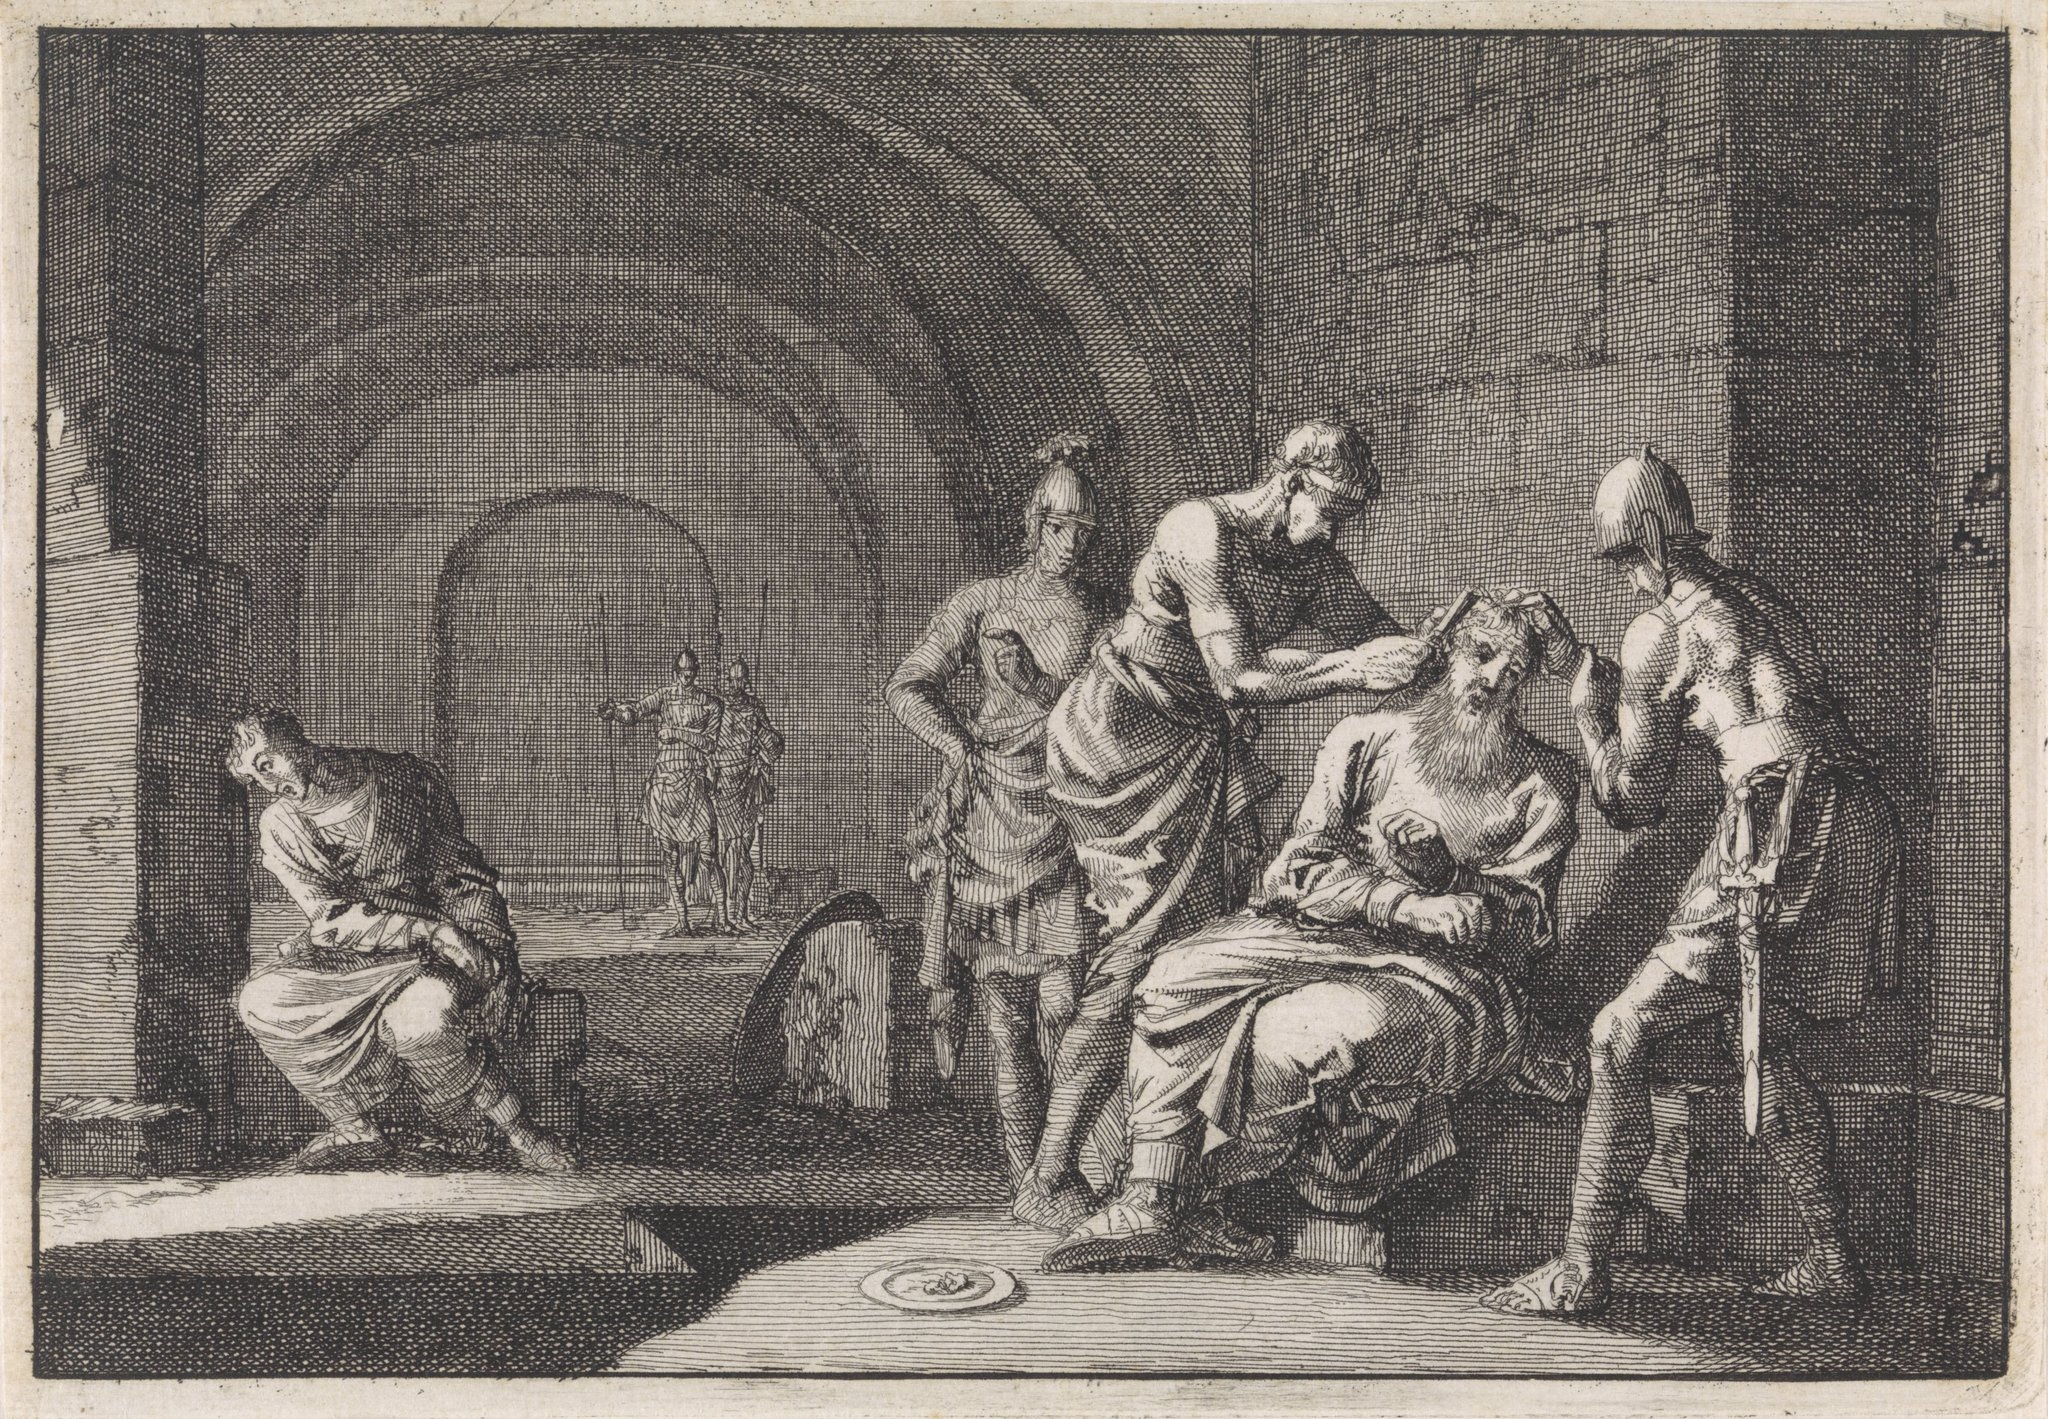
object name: print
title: Hyrkanus de oren afgesneden in de gevangenis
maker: jan luyken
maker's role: draughtsman, print maker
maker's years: 1649-1712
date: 1704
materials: paper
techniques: etching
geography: amsterdam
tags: prison, jail, violent death by removal of parts of the body by cutting, sawing, tearing - ee - death not certain; wounded person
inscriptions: collector's mark: Lugt 2228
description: Prent ook gebruikt als boekillustratie in: Josephus, Flavius. Alle de Werken, 2 delen. Amsterdam: Pieter Mortier, 1704, dl. 1, p. 352.